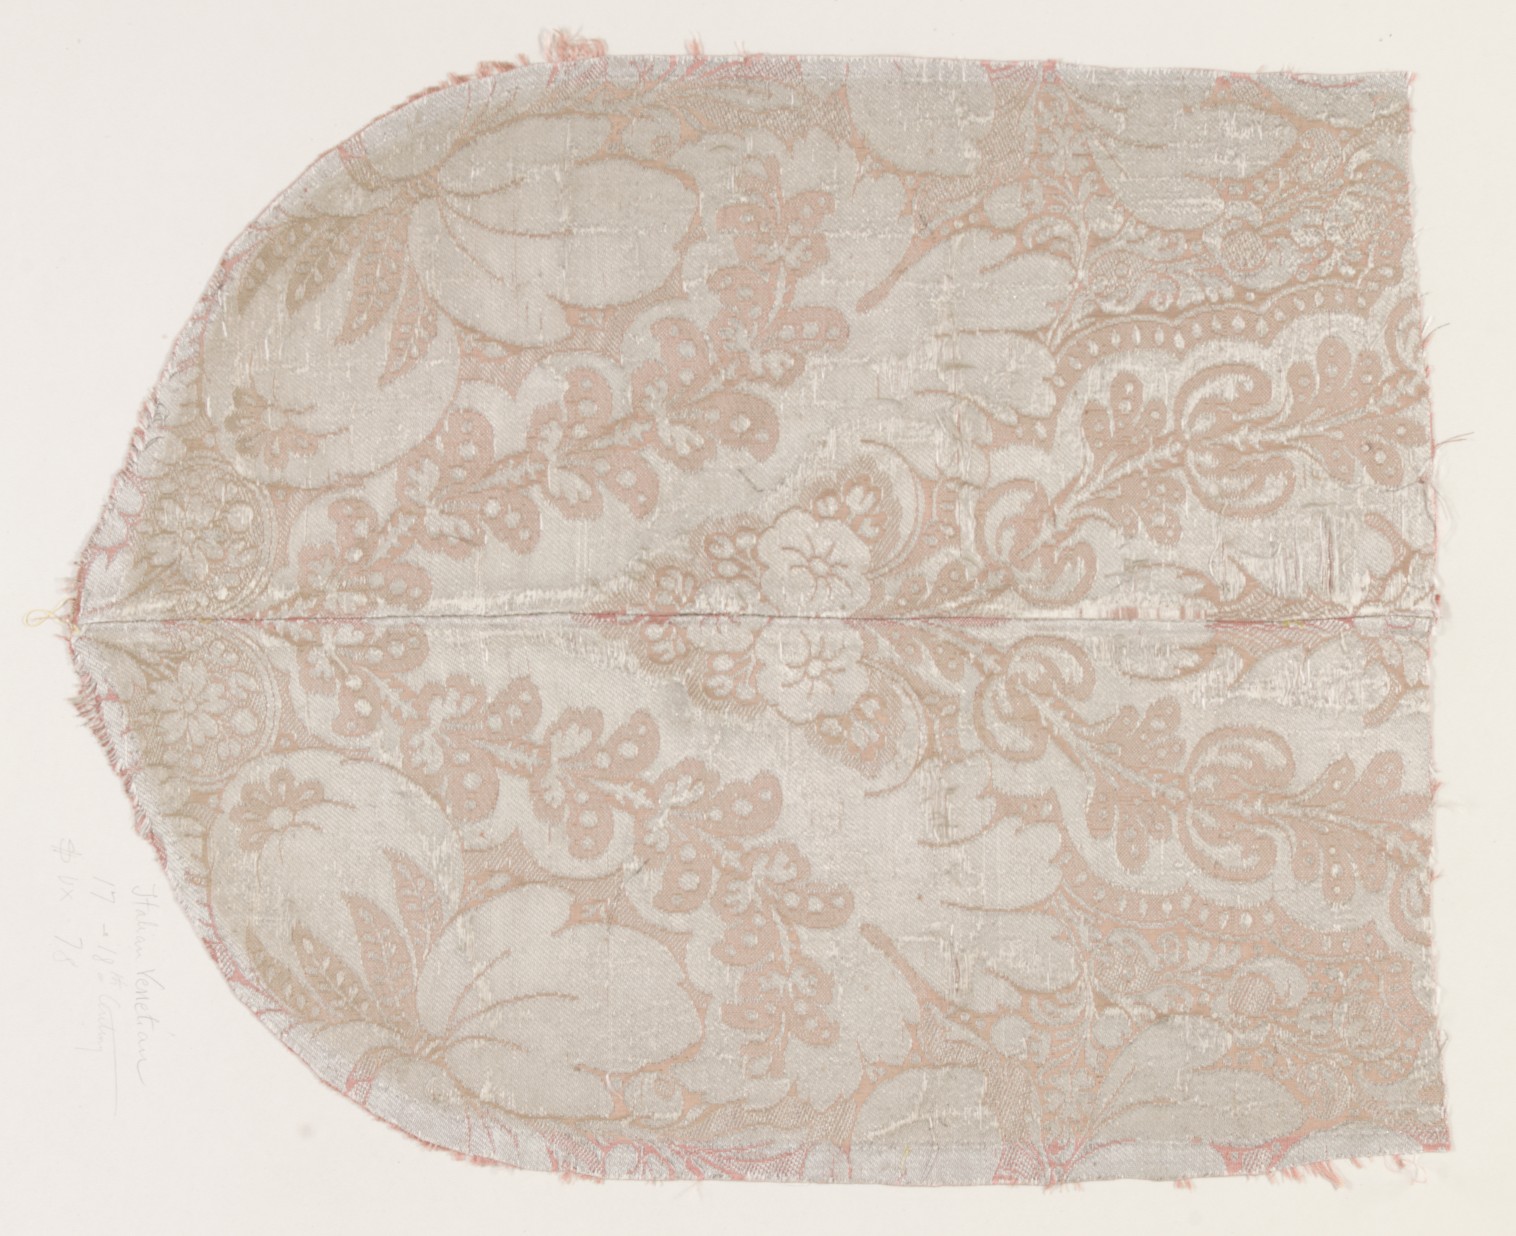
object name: fragment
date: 1701-1800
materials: metal thread, silk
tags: flowers,leaves